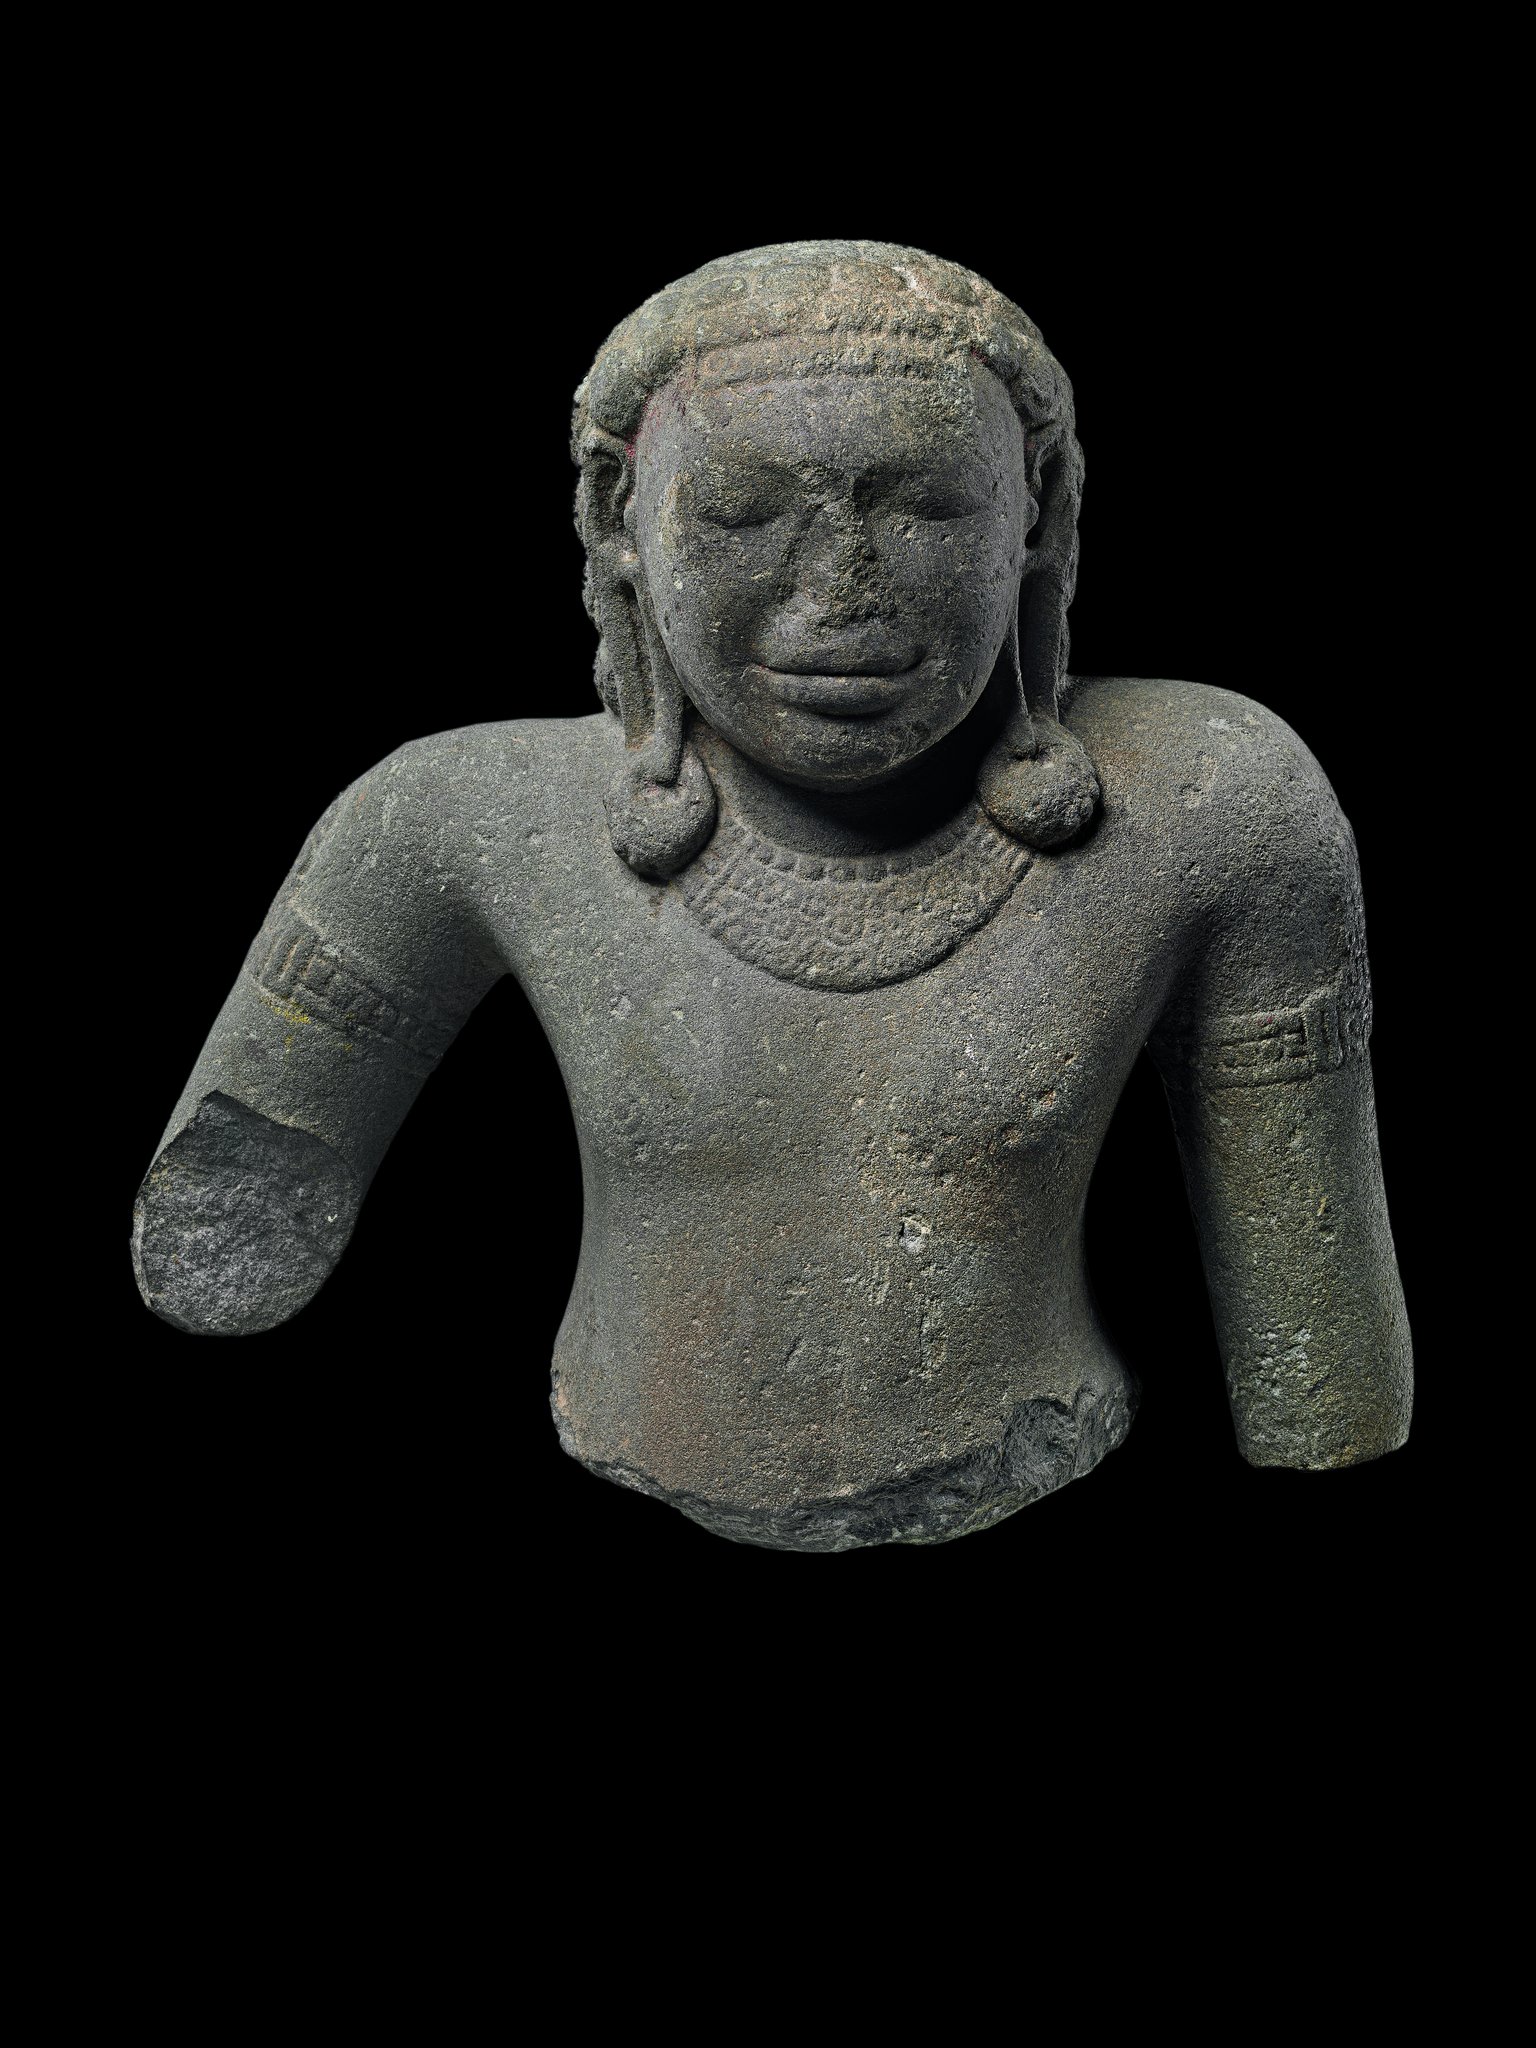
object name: bust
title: Yaksha, possibly Kubera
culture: vietnamese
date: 567-633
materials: stone